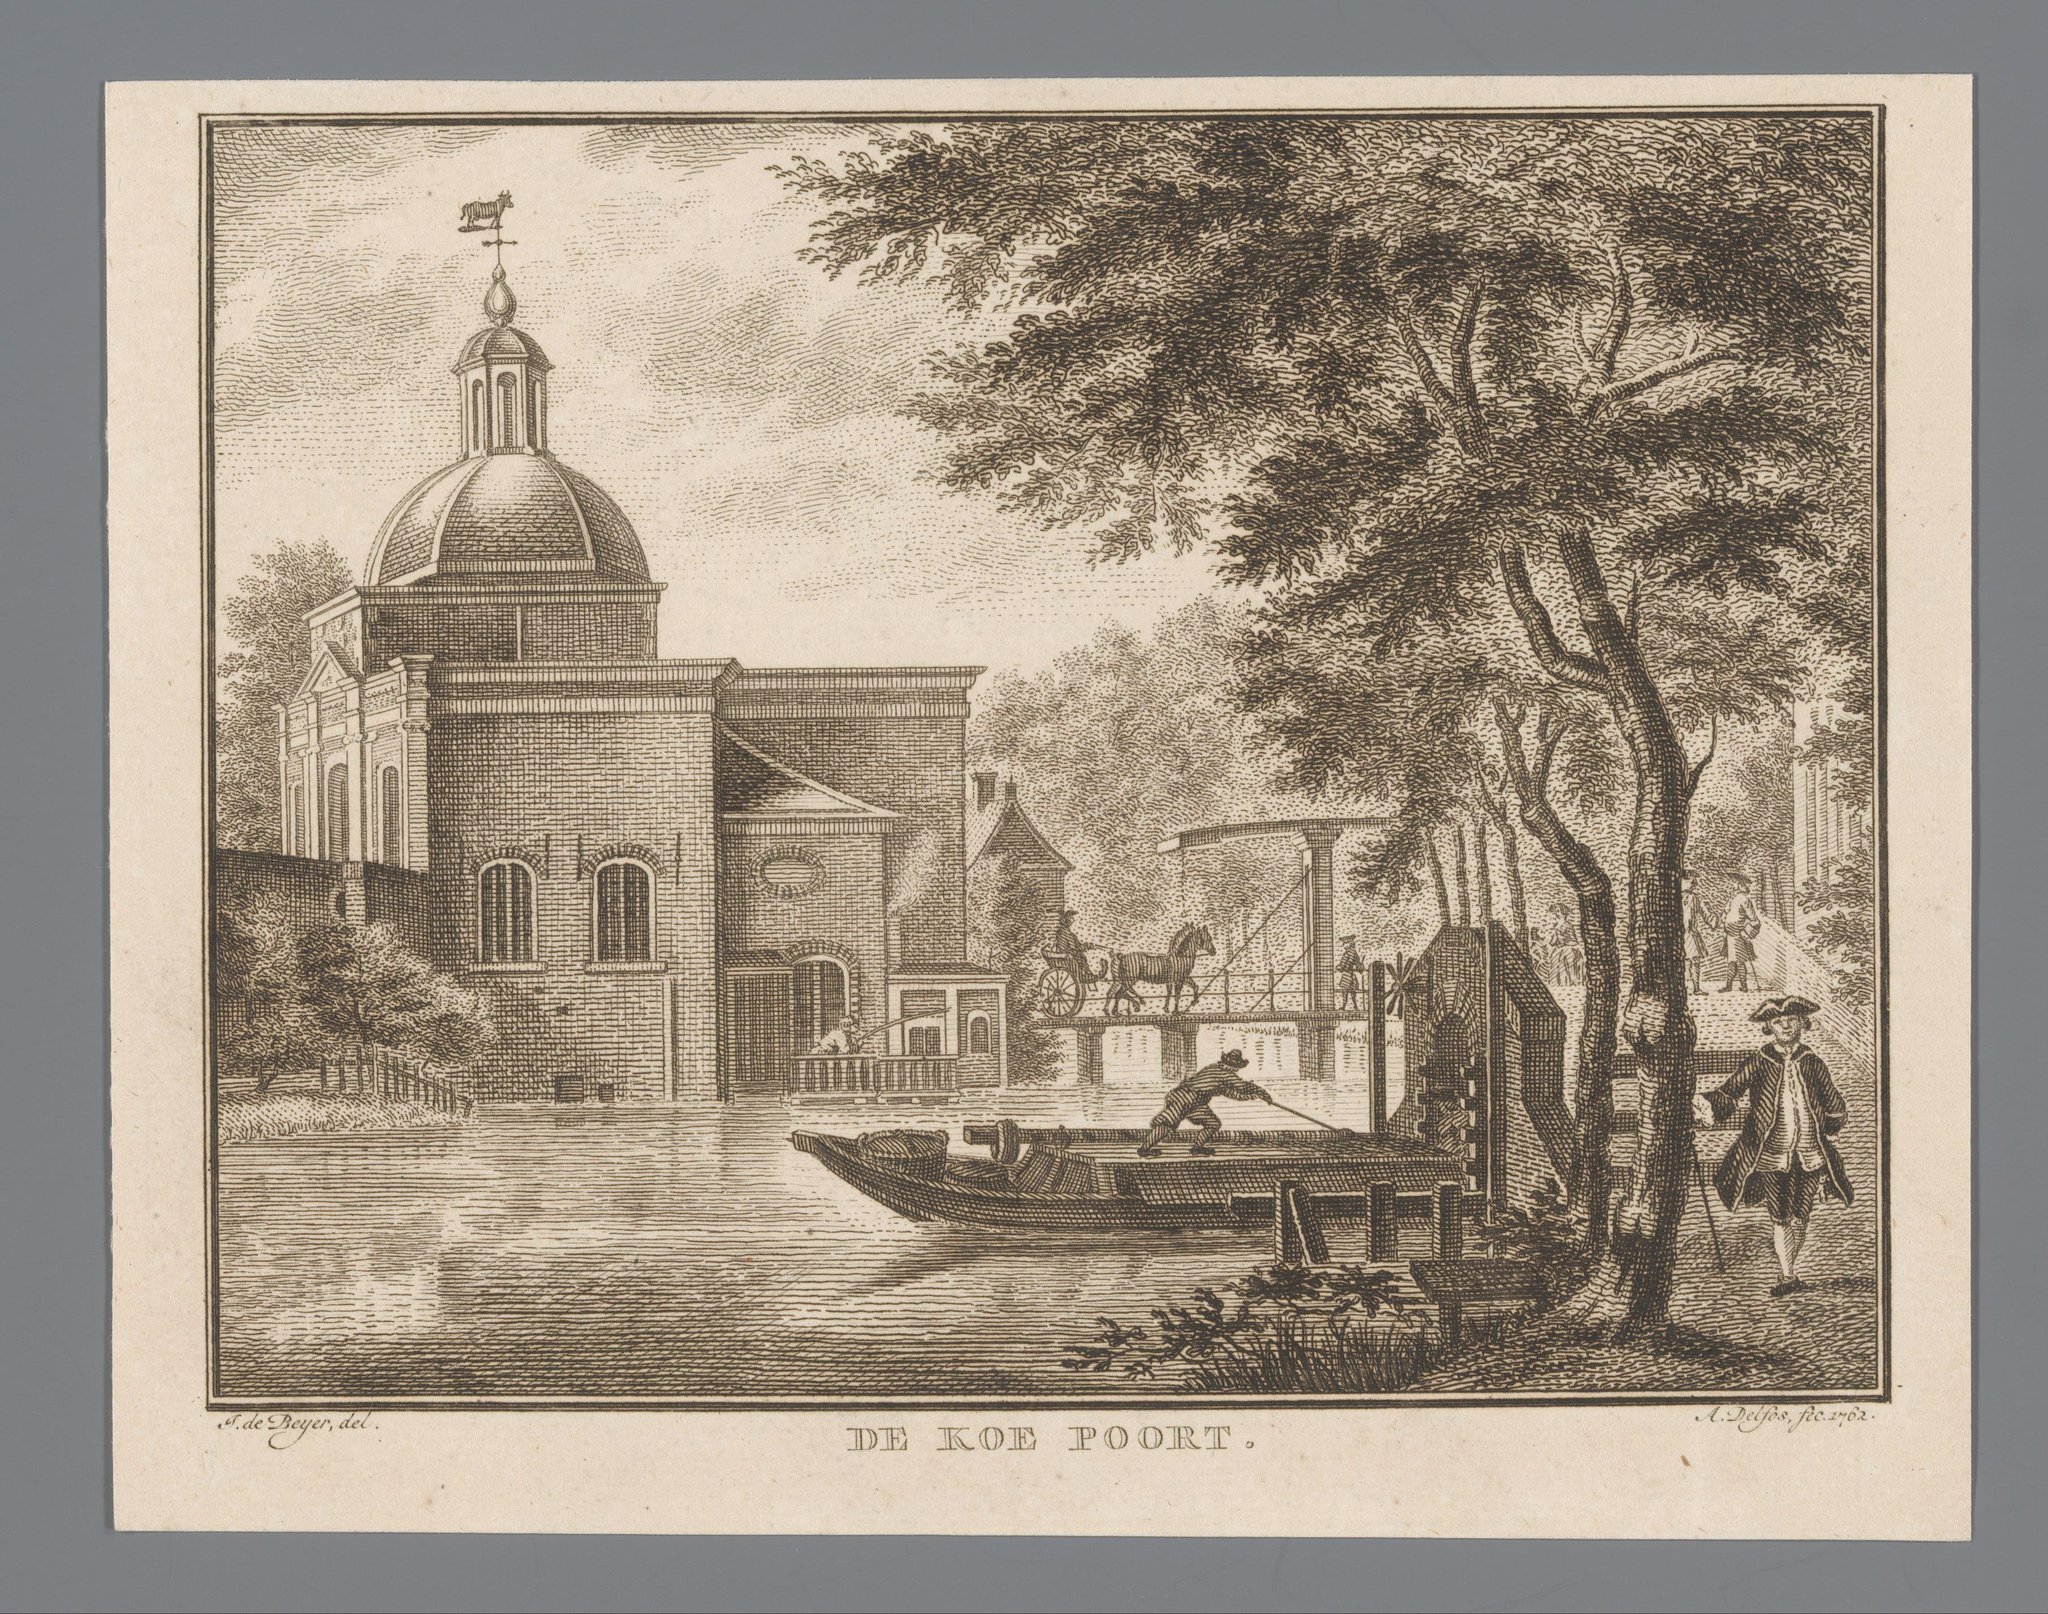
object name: print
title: Gezicht op de Koepoort te Leiden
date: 1762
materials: paper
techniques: etching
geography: leiden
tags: city-gate, canals, waters (in city) (+ city(-scape) with figures, staffage)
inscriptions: date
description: Prent uit: Mieris, Frans van. Beschrijving der stad Leyden, haar gelegenheid, oorsprong (...). Leiden: Weduwe Abraham Honkoop en Cornelis van Hoogeveen junior, 1762, dl. 1, tussen p. 14 en 15.